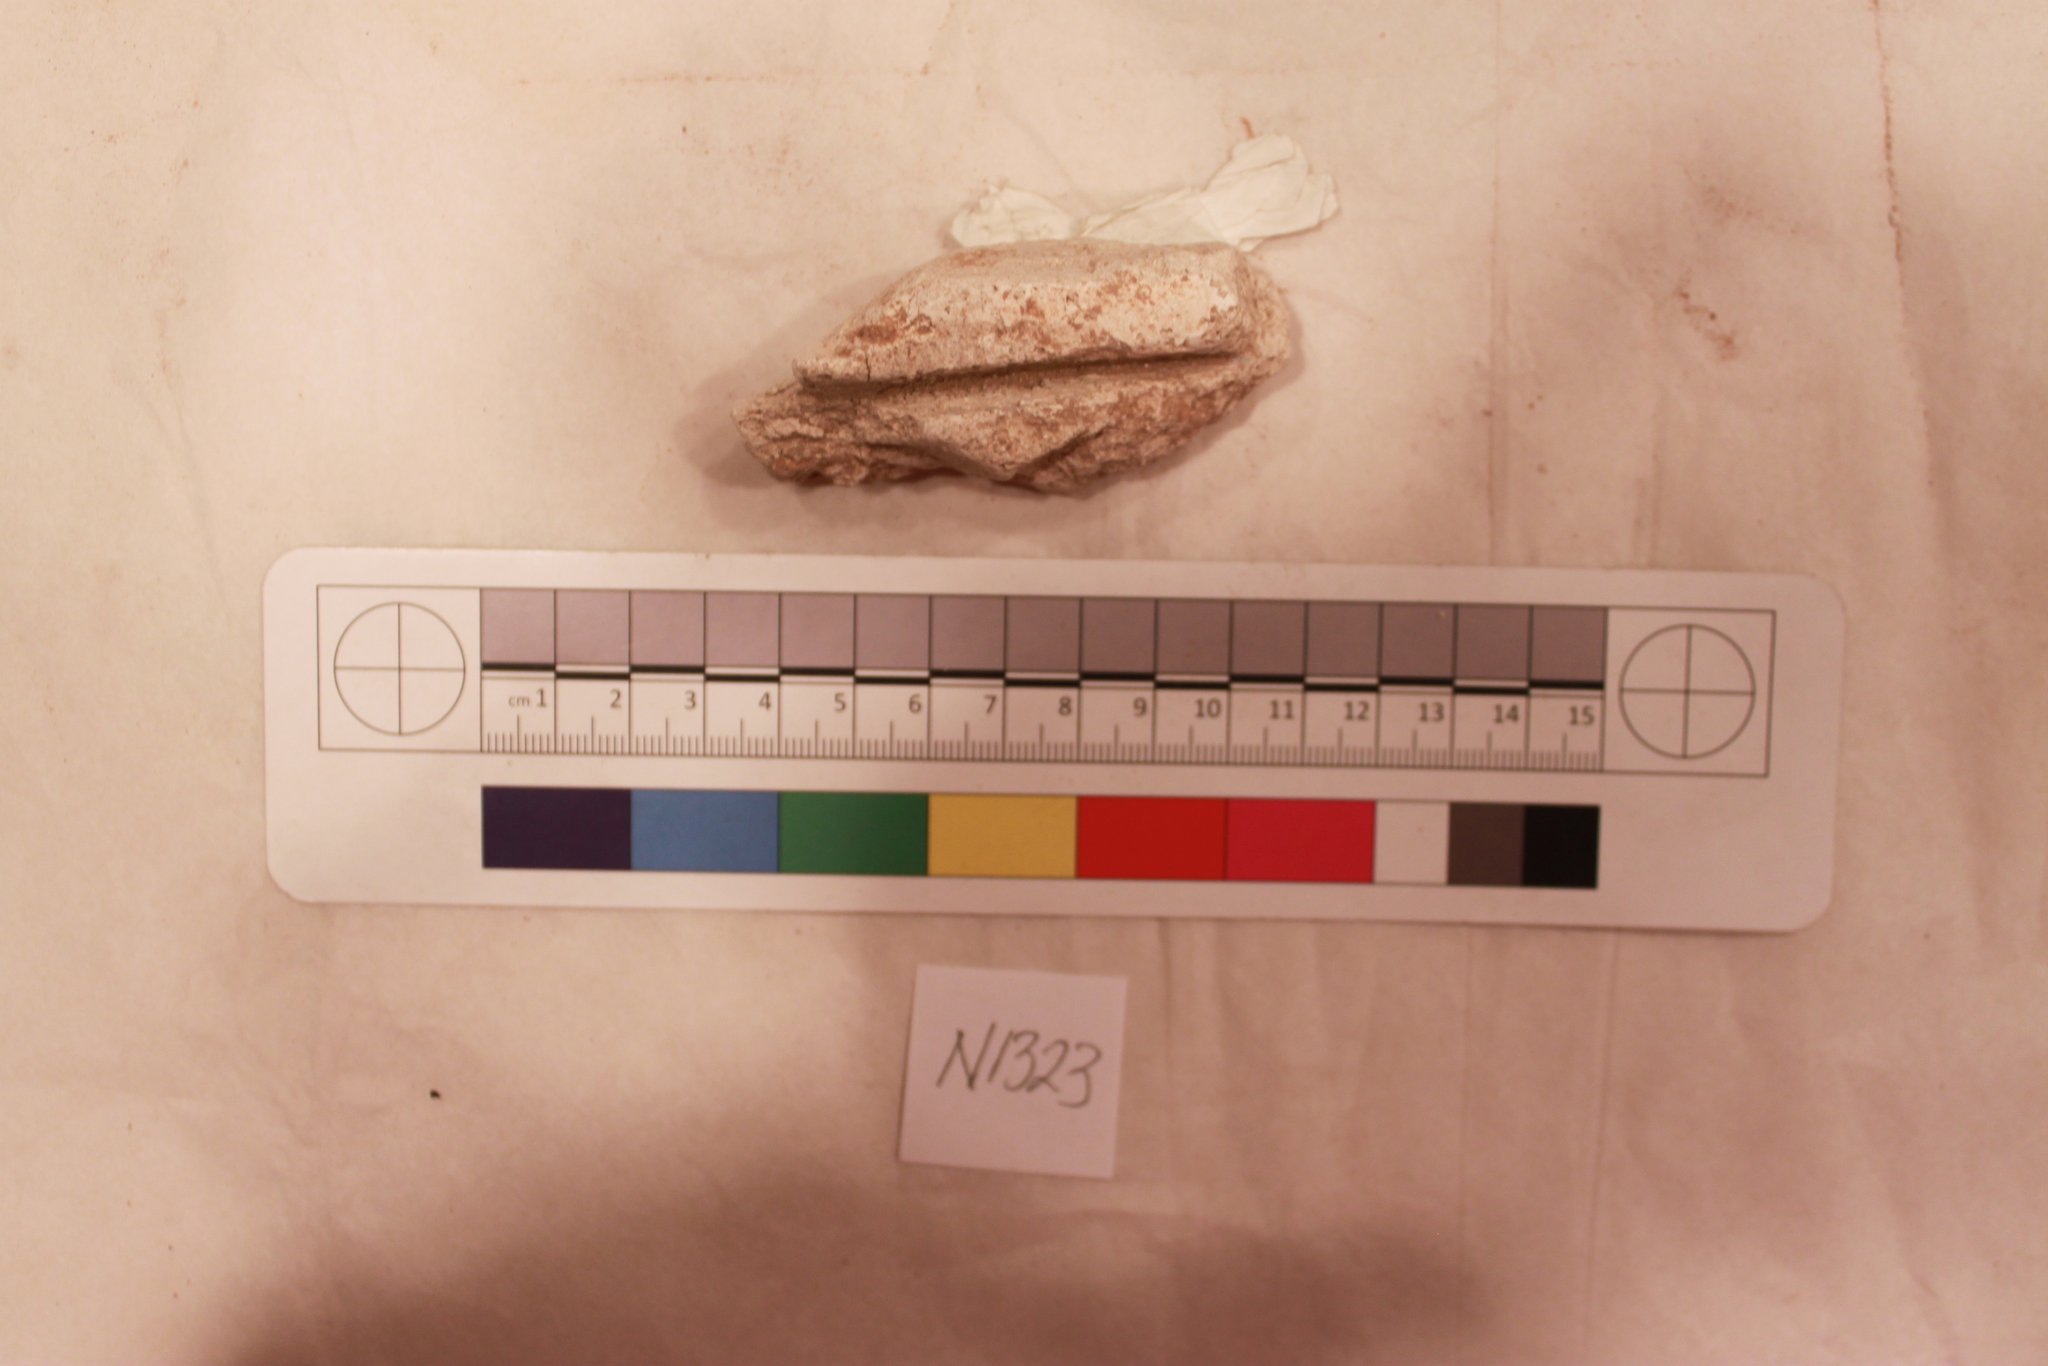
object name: fragment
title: Stucco Fragment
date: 701-1200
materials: plaster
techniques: carving, painting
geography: iran